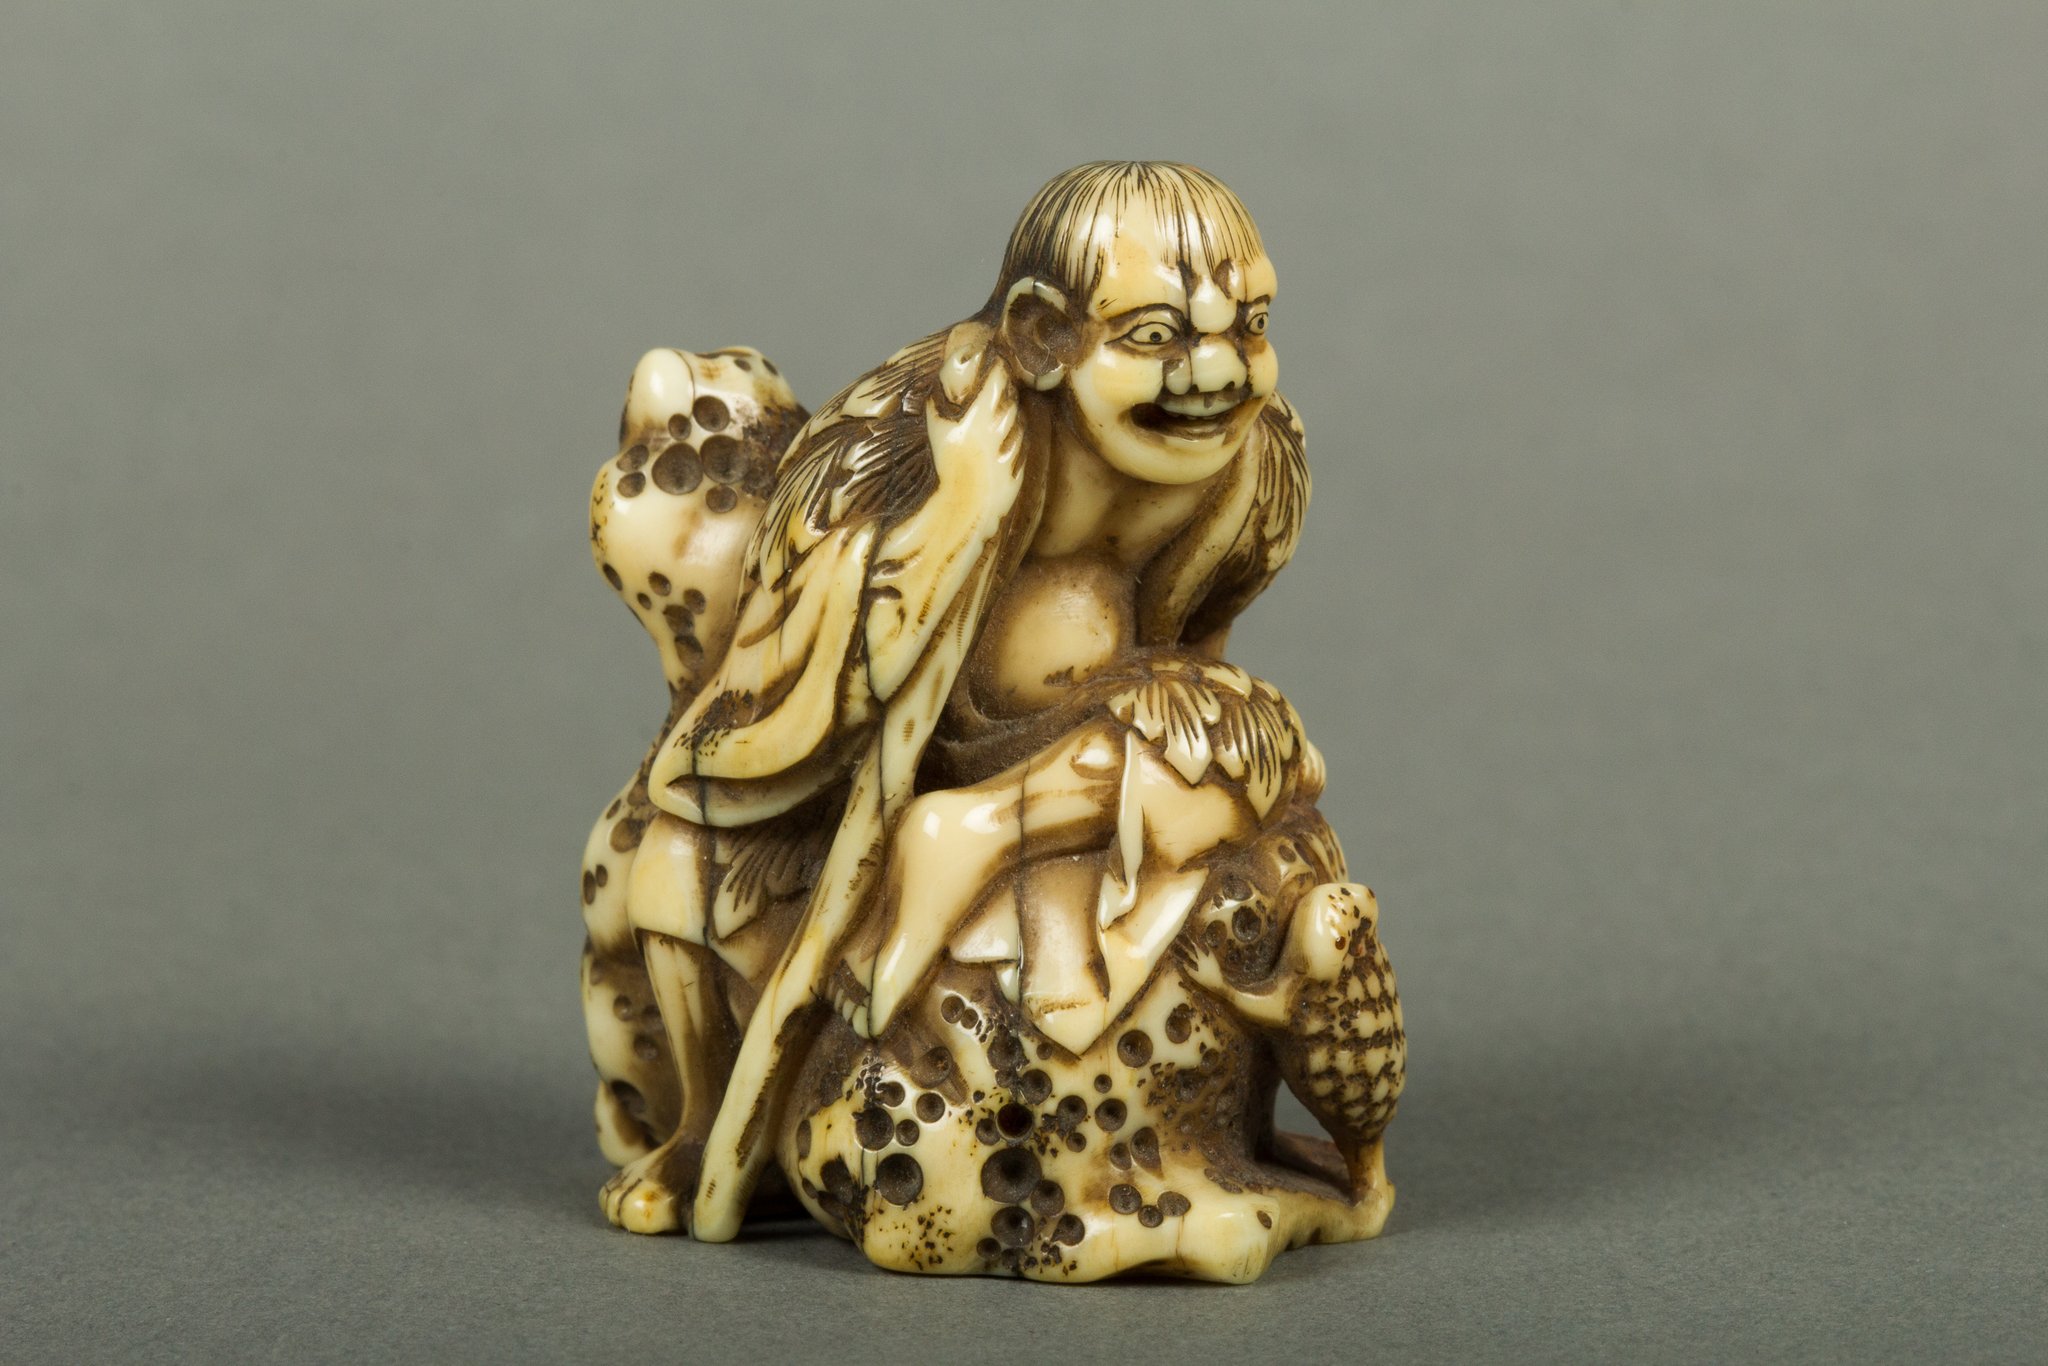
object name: netsuke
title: Netsuke of Old Man Sitting on a Rock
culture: japanese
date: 1801-1900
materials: ivory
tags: men